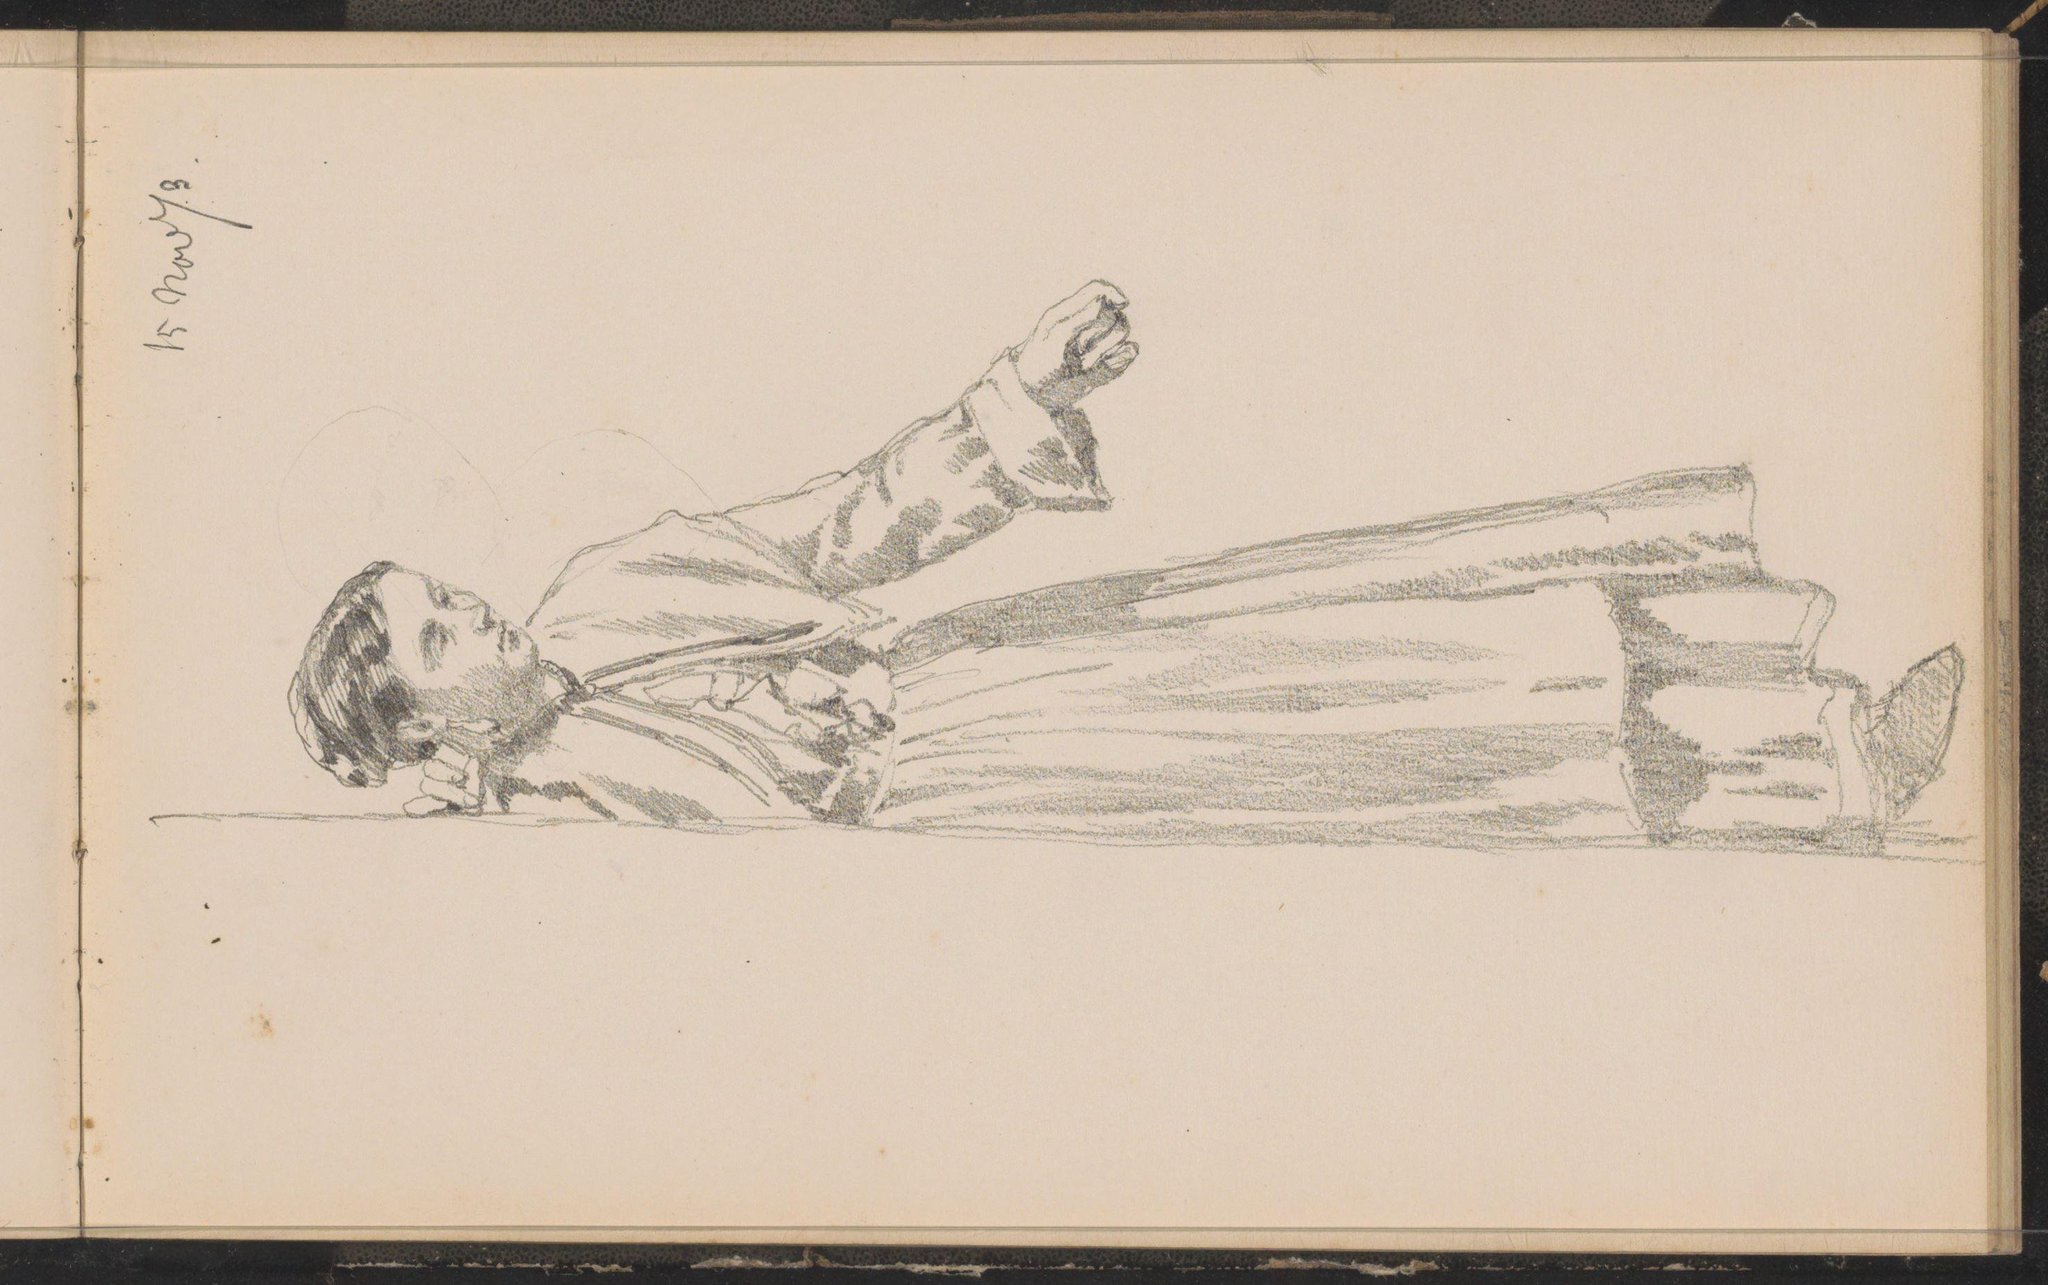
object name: sketchbook leaf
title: Vrouw, deels achter een muur of deur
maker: cornelis springer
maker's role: draughtsman, painter, print maker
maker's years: 1817-1891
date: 1873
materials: paper, pencil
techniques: stumping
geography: netherlands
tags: standing figure - aa - female human figure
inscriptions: date: ‘15 nov 73’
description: Vrouw met oorbellen. Ze staat deels achter een muur of deur. Blad 26 uit een schetsboek met 46 bladen.